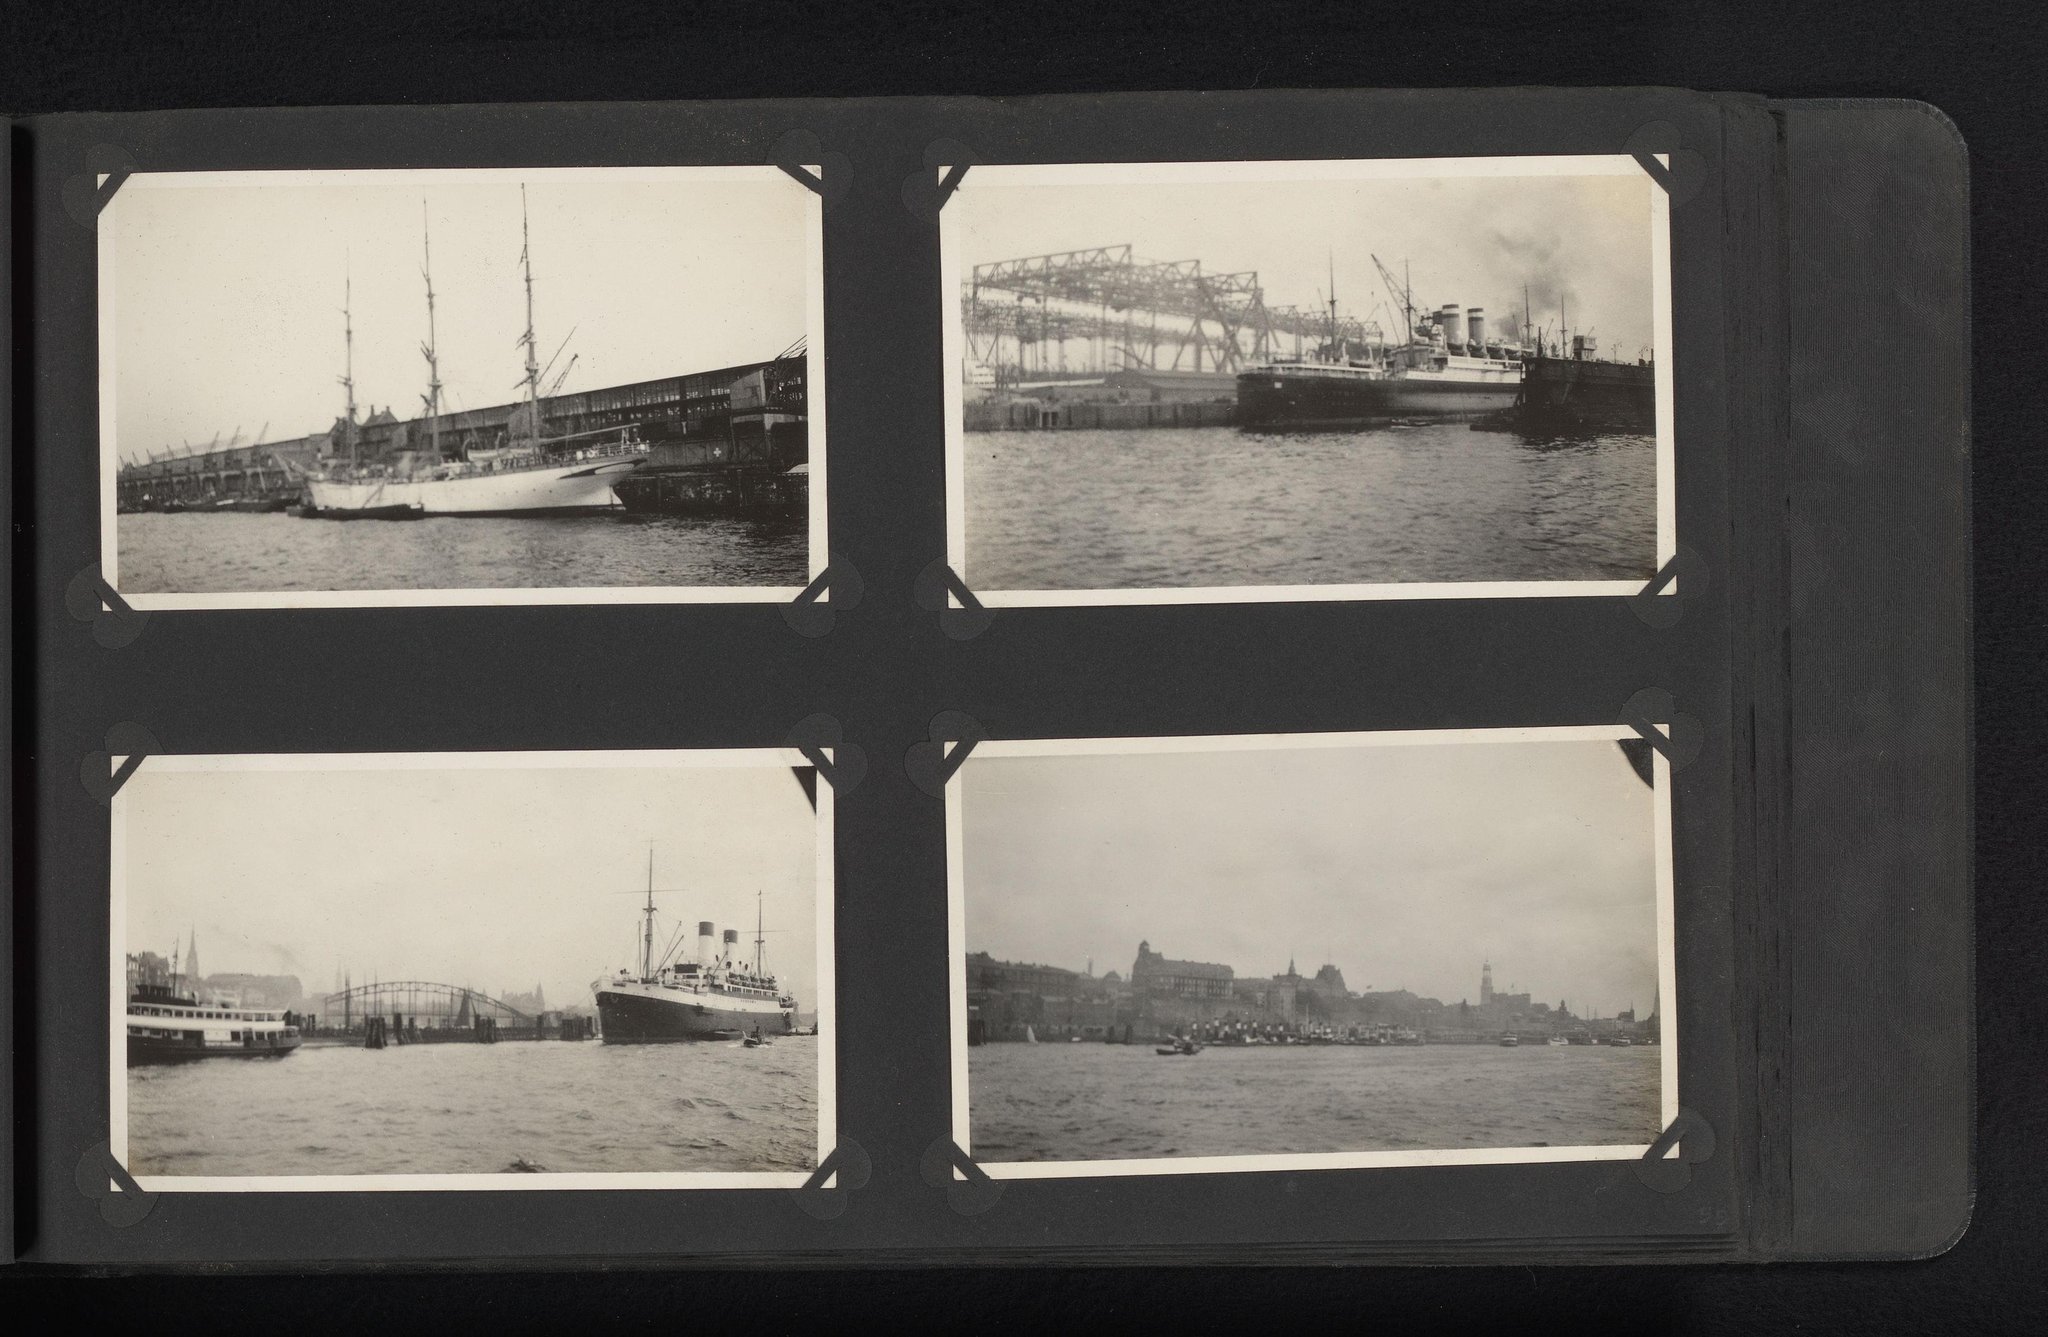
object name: album leaf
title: Vier foto's van de haven van Hamburg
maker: hendrik herman van den berg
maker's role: amateurfotograaf, jurist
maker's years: 1875-1944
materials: paper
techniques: gelatin silver print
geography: hamburg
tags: harbour, steamship, motorship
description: Deze foto's maken deel uit van een album.